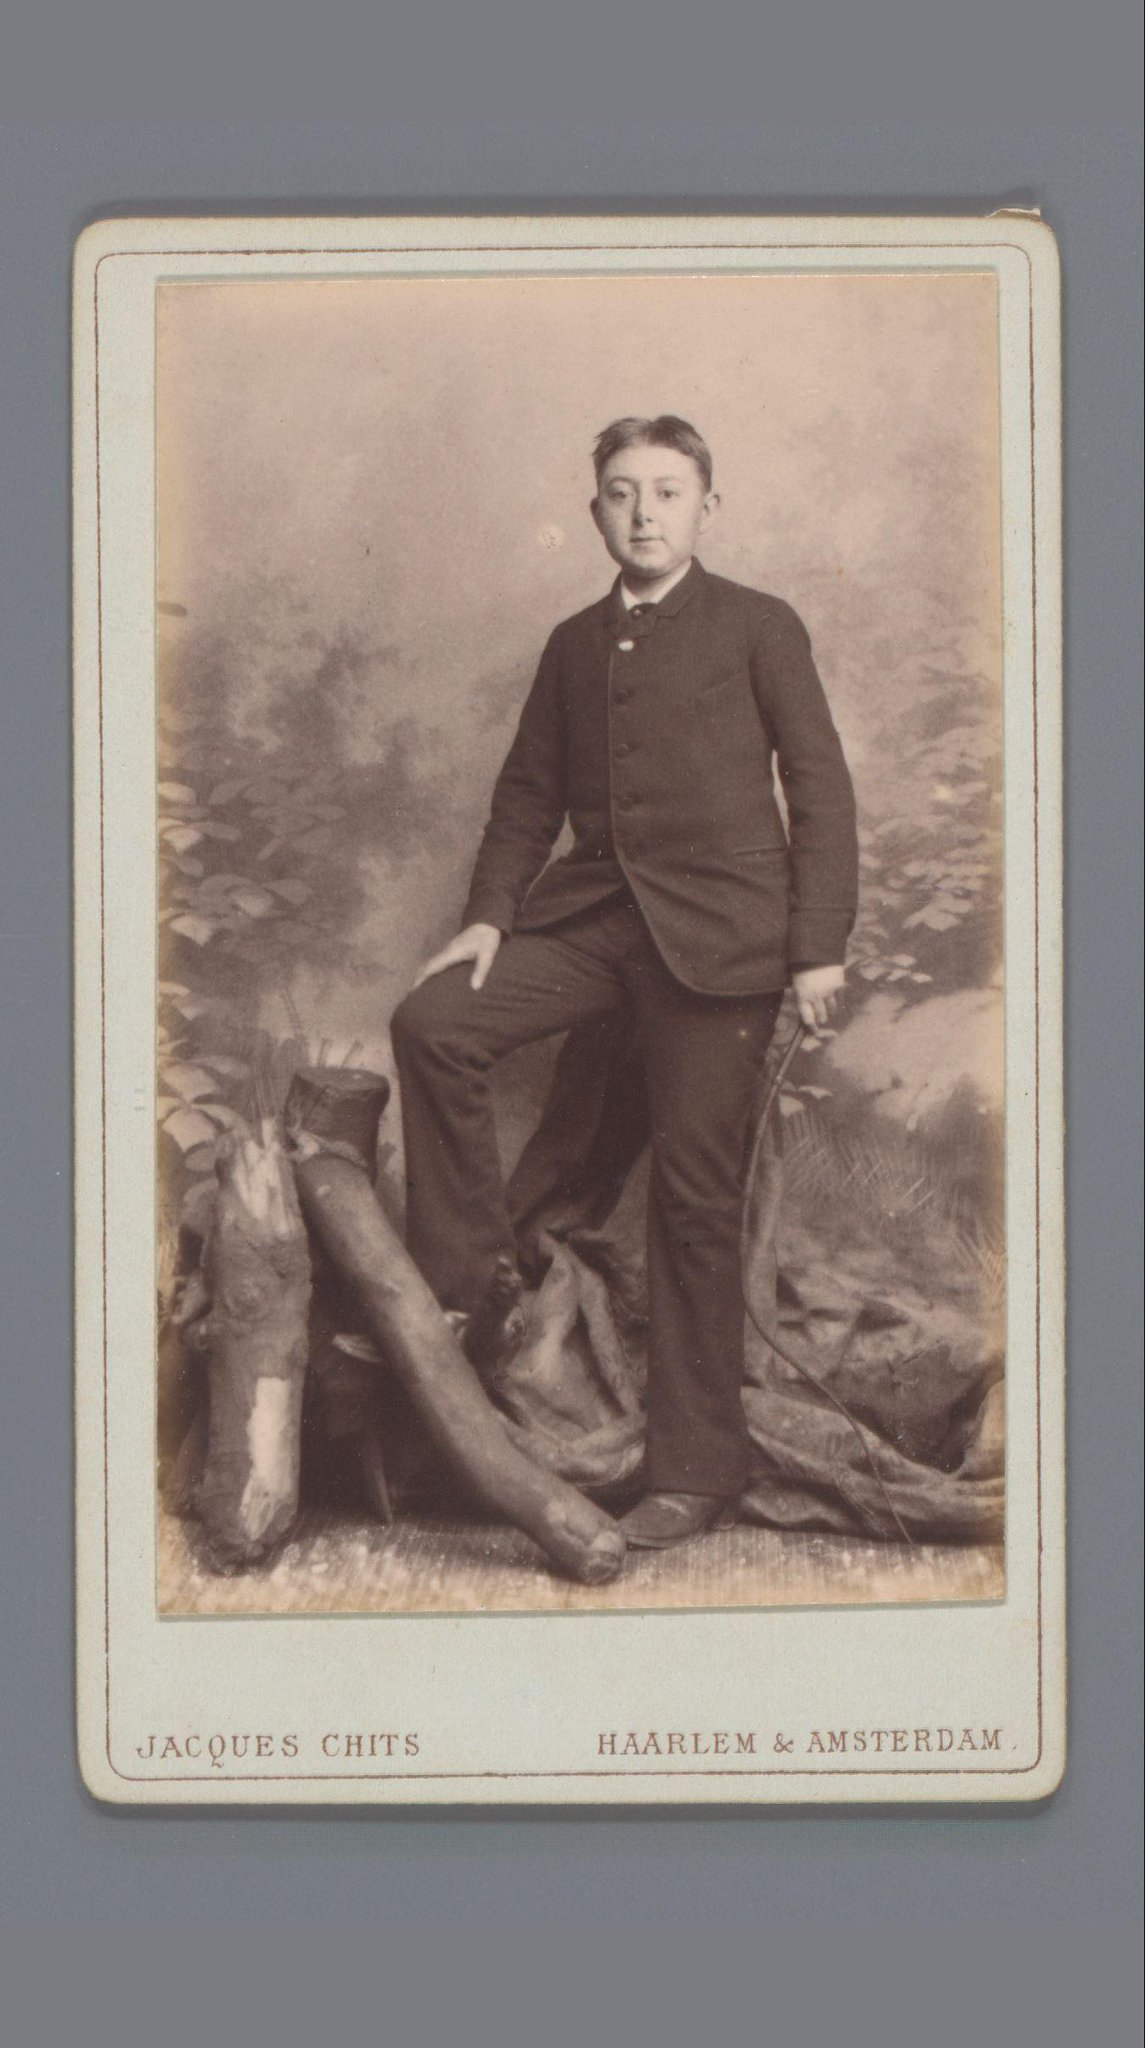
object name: carte de visite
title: Portret van een onbekende jonge man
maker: jacques chits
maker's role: fotograaf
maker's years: 1835-1917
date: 1881-1887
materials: paper, cardboard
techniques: collodion silver print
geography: haarlem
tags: youth, adolescent, anonymous historical person portrayed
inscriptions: address: ‘Haarlem/ Waaigat/ No. 14./ Amsterdam/ Plantage/ Kerklaan No. 15/ over de Koningskroon.’, inscription: ‘De plaat blijft ter nabestelling bewaard.’